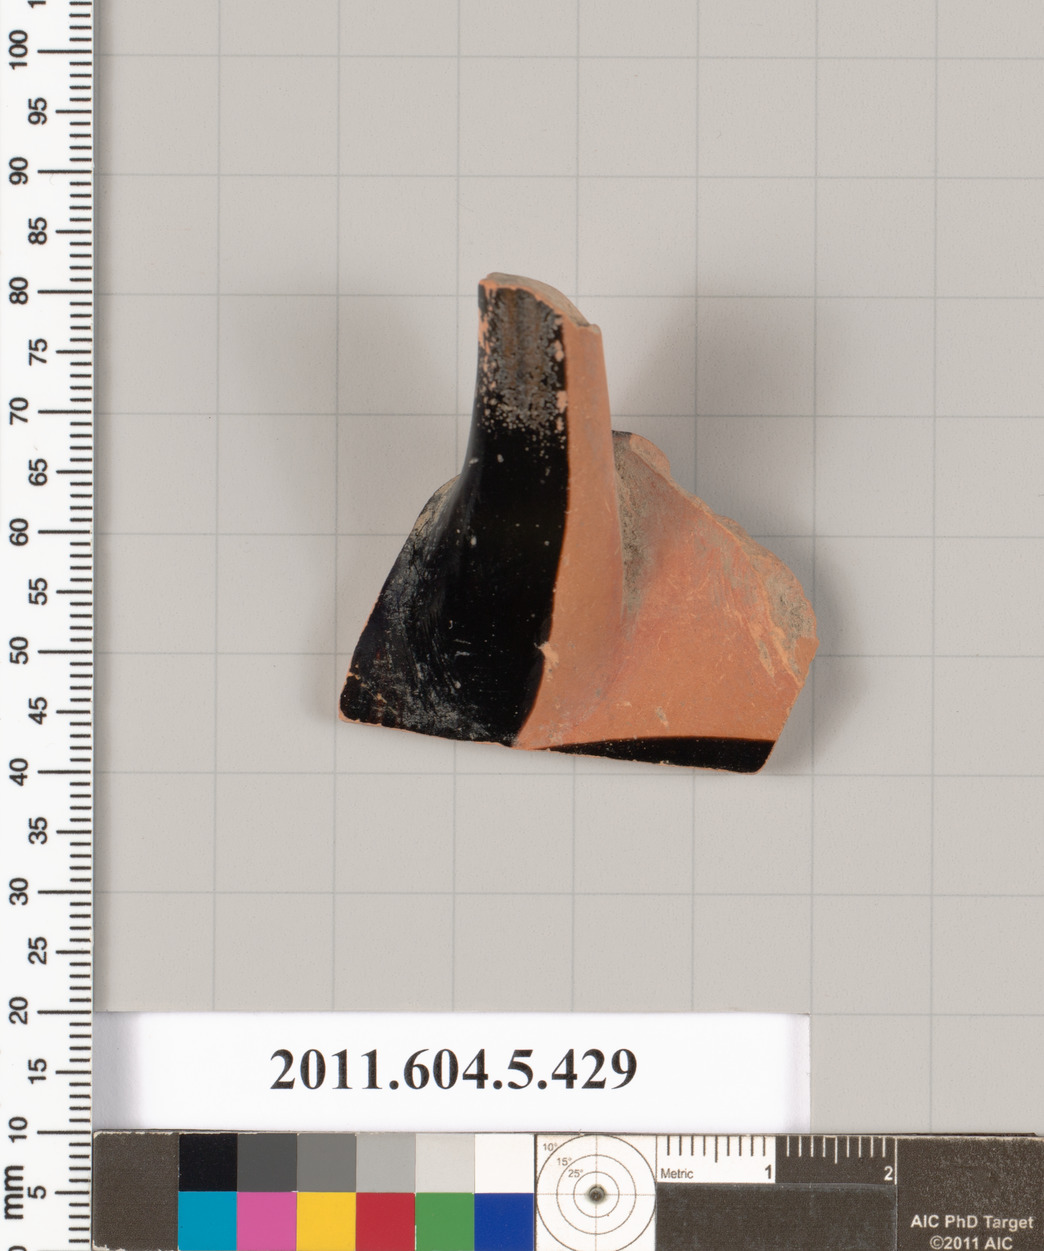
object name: kylix fragment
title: Terracotta fragment of a kylix (drinking cup)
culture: greek, attic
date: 600-401 BCE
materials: terracotta